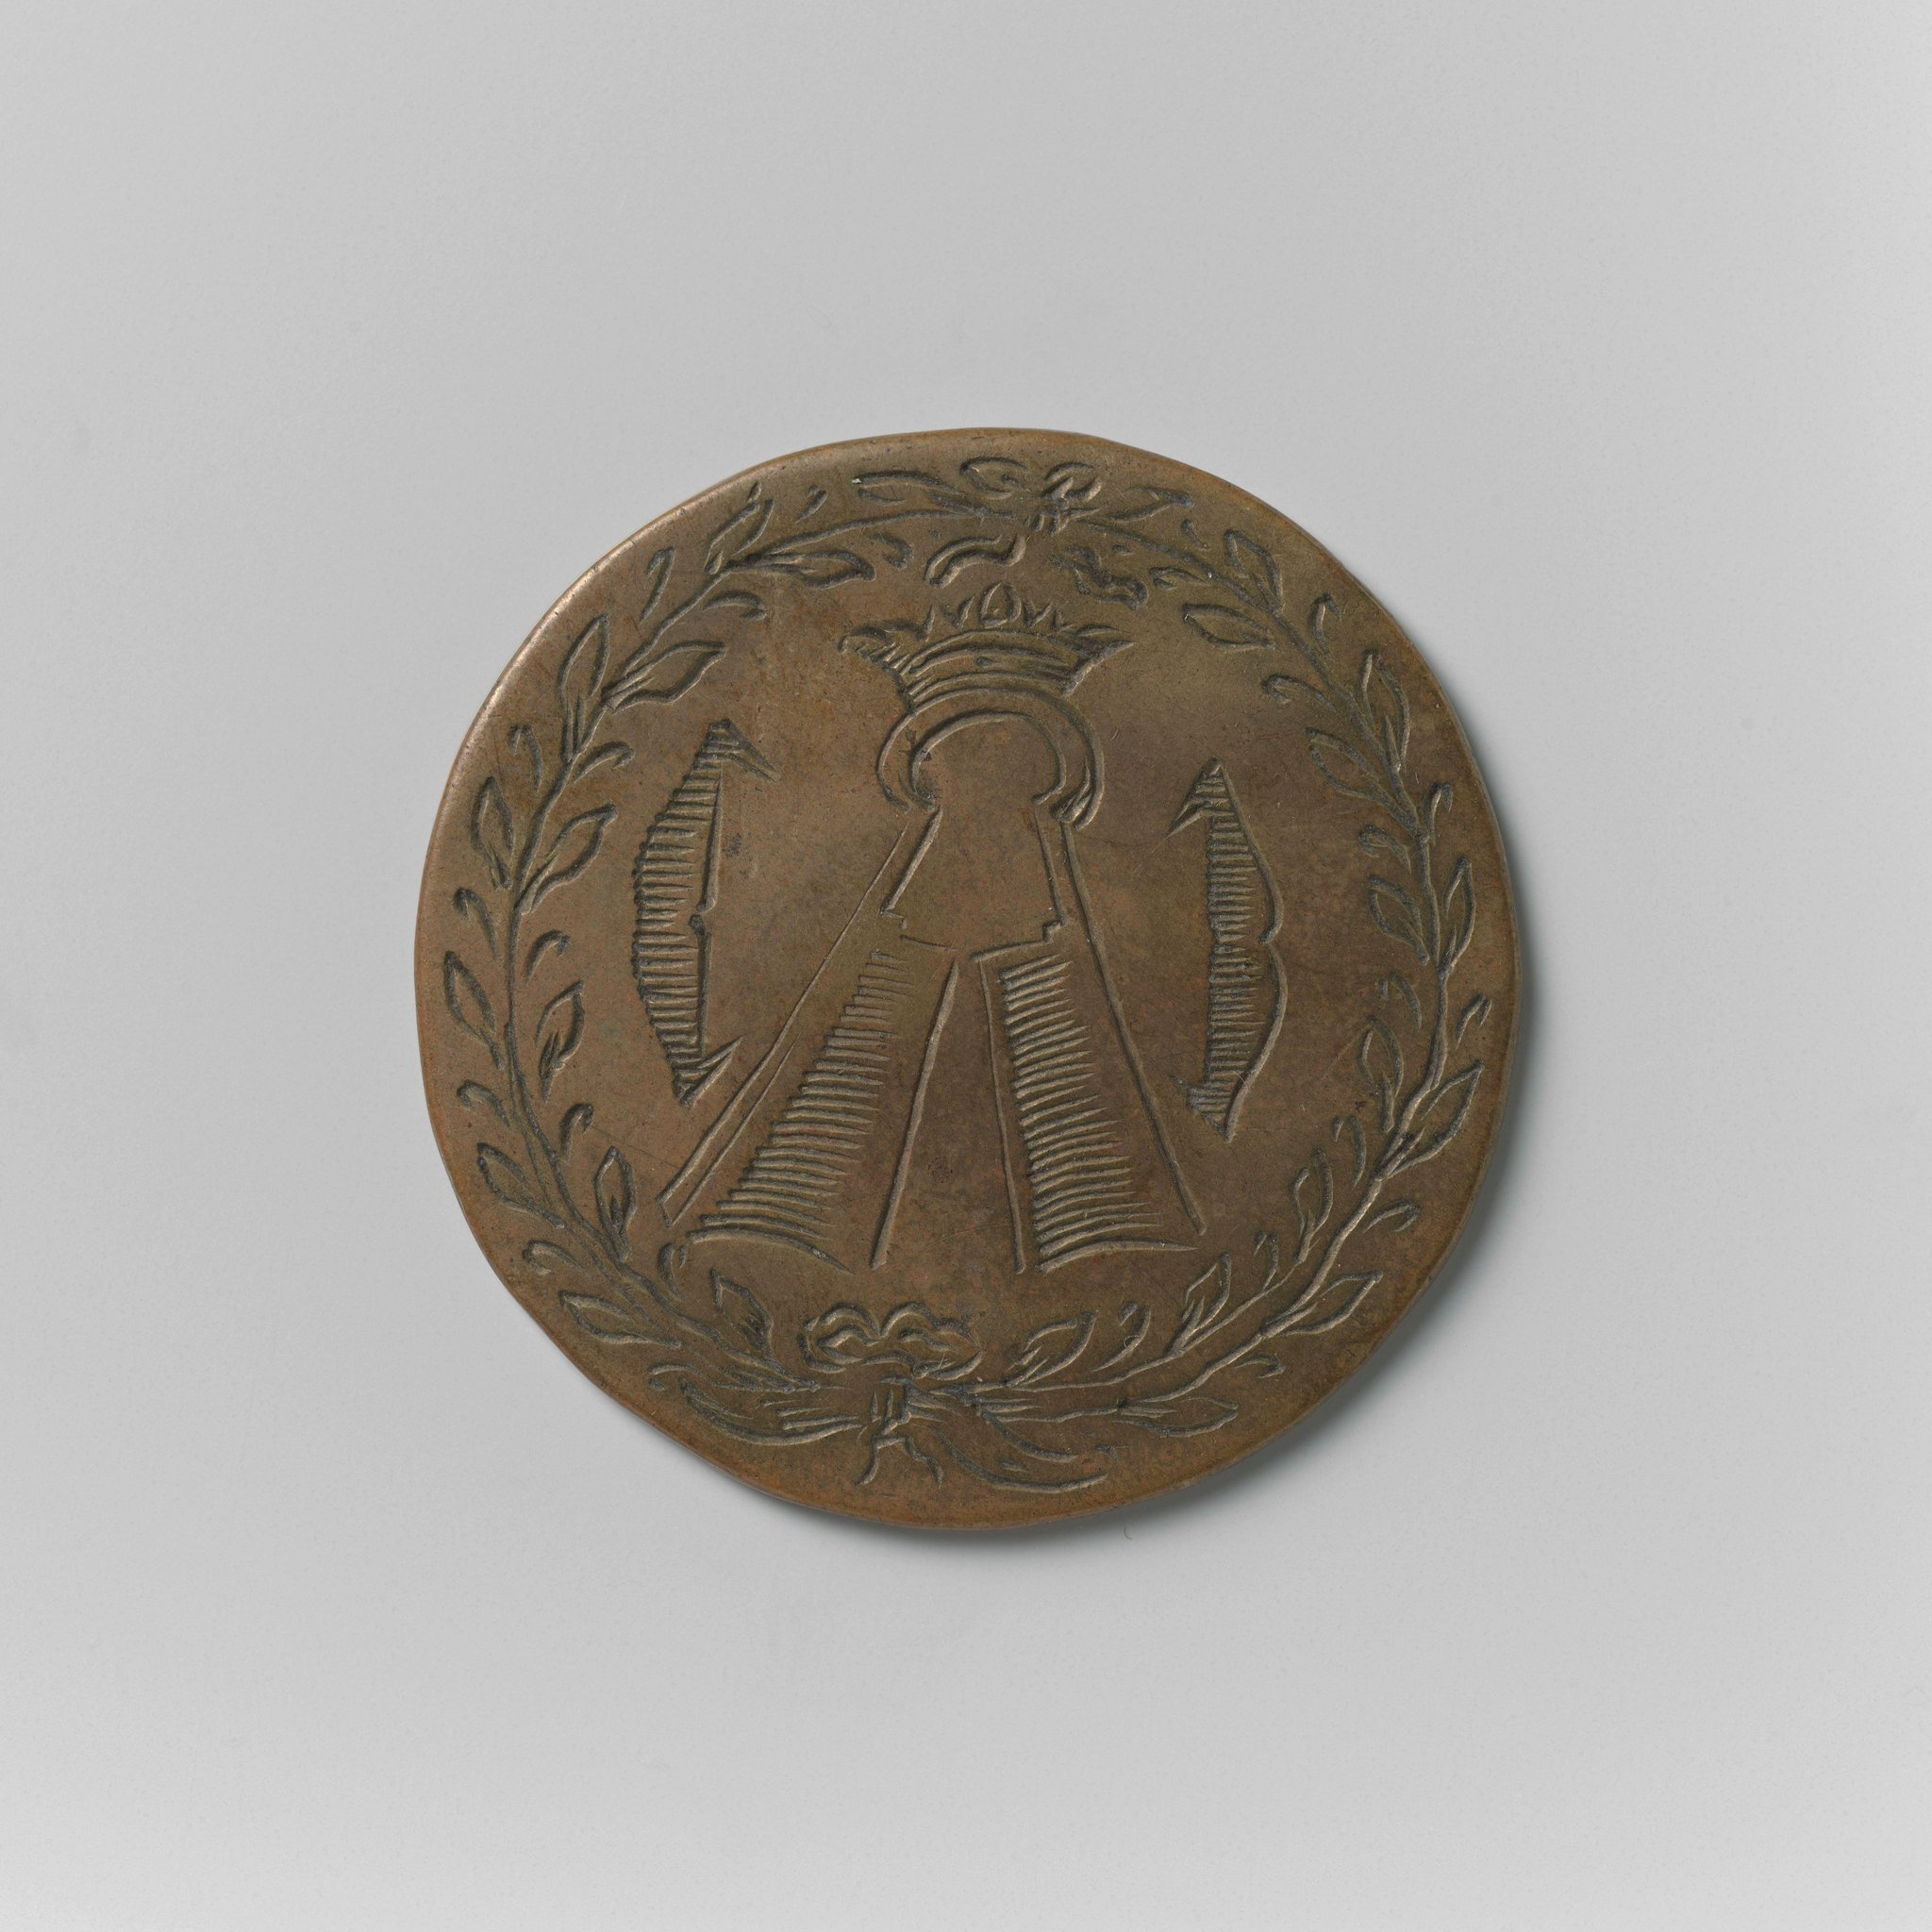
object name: medal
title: Presentiepenning van het Lakenbereiders en Droogscheerdersgilde te Amsterdam, 1653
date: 1653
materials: brass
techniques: engraving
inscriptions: inscription: ‘Pieter / Noppe’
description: Ronde plaat messing gegraveerd op de voorzijde een gekroonde droogscheerdersschaar in krans, op de keerzijde een gekroond wapenschild Amsterdam met dragers boven een inscriptieruimte, op naam van Pieter Noppe